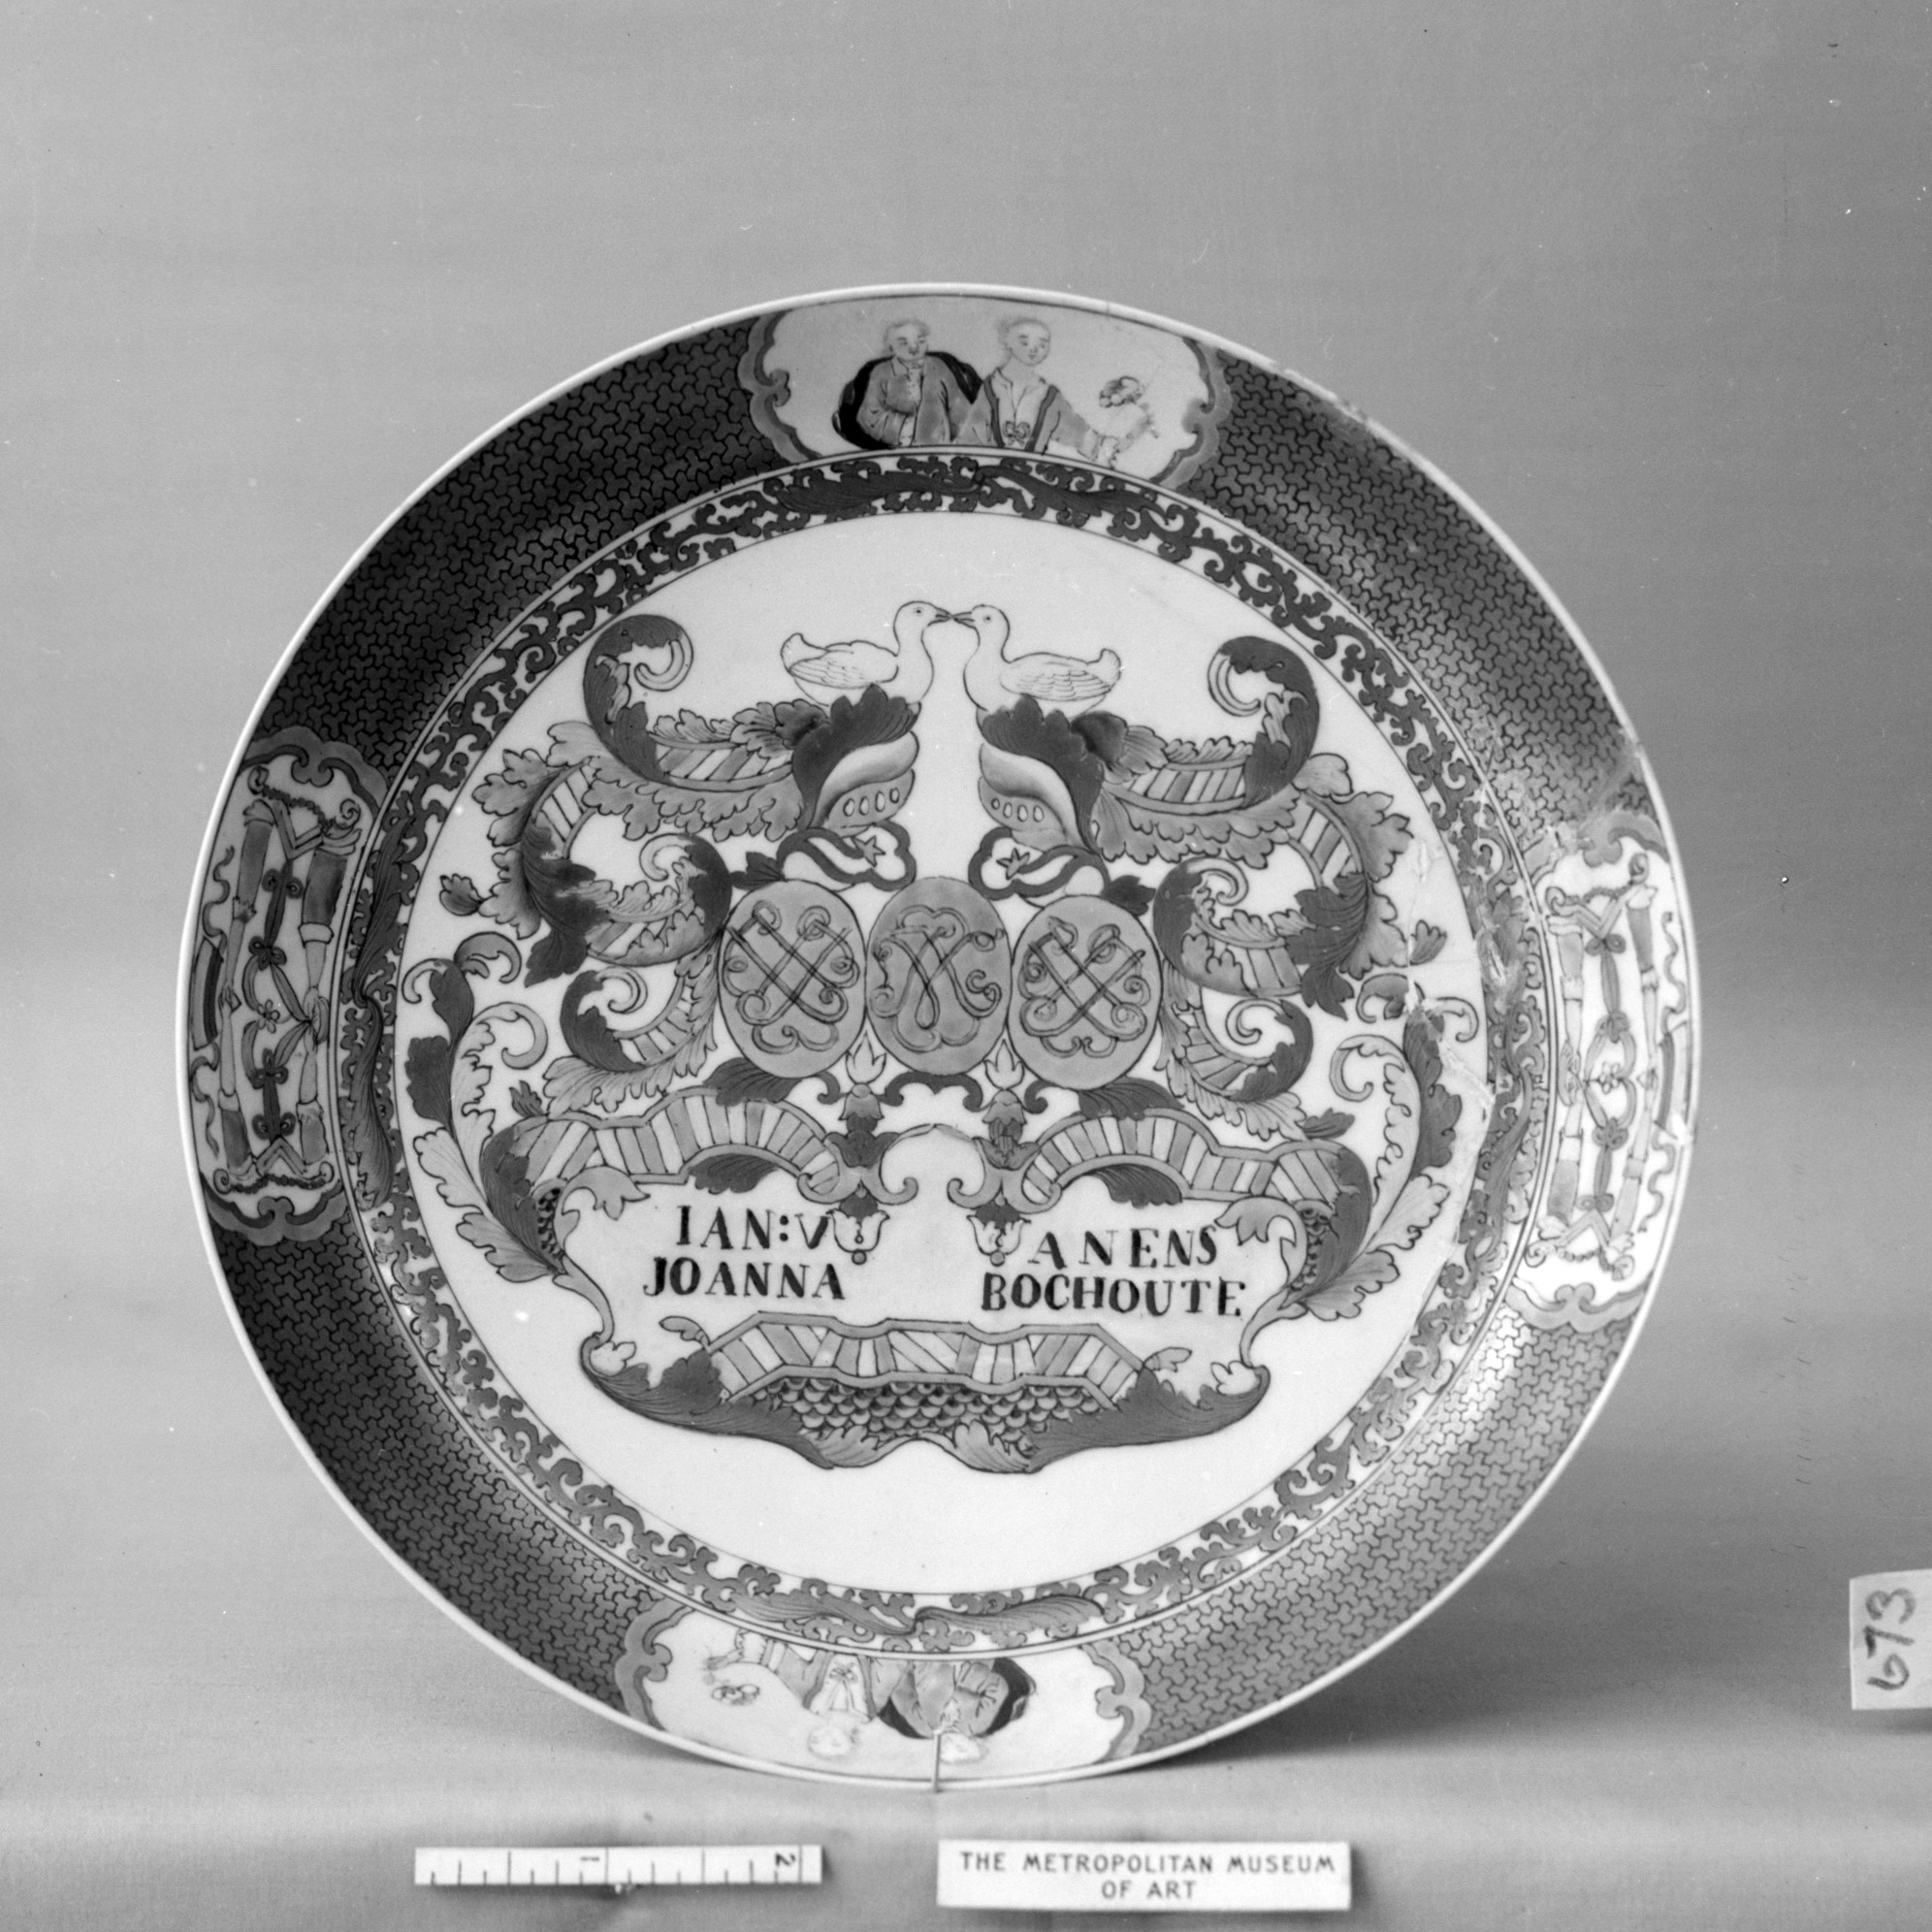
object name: plate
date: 1730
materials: hard paste porcelain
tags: birds,men,women,insignia